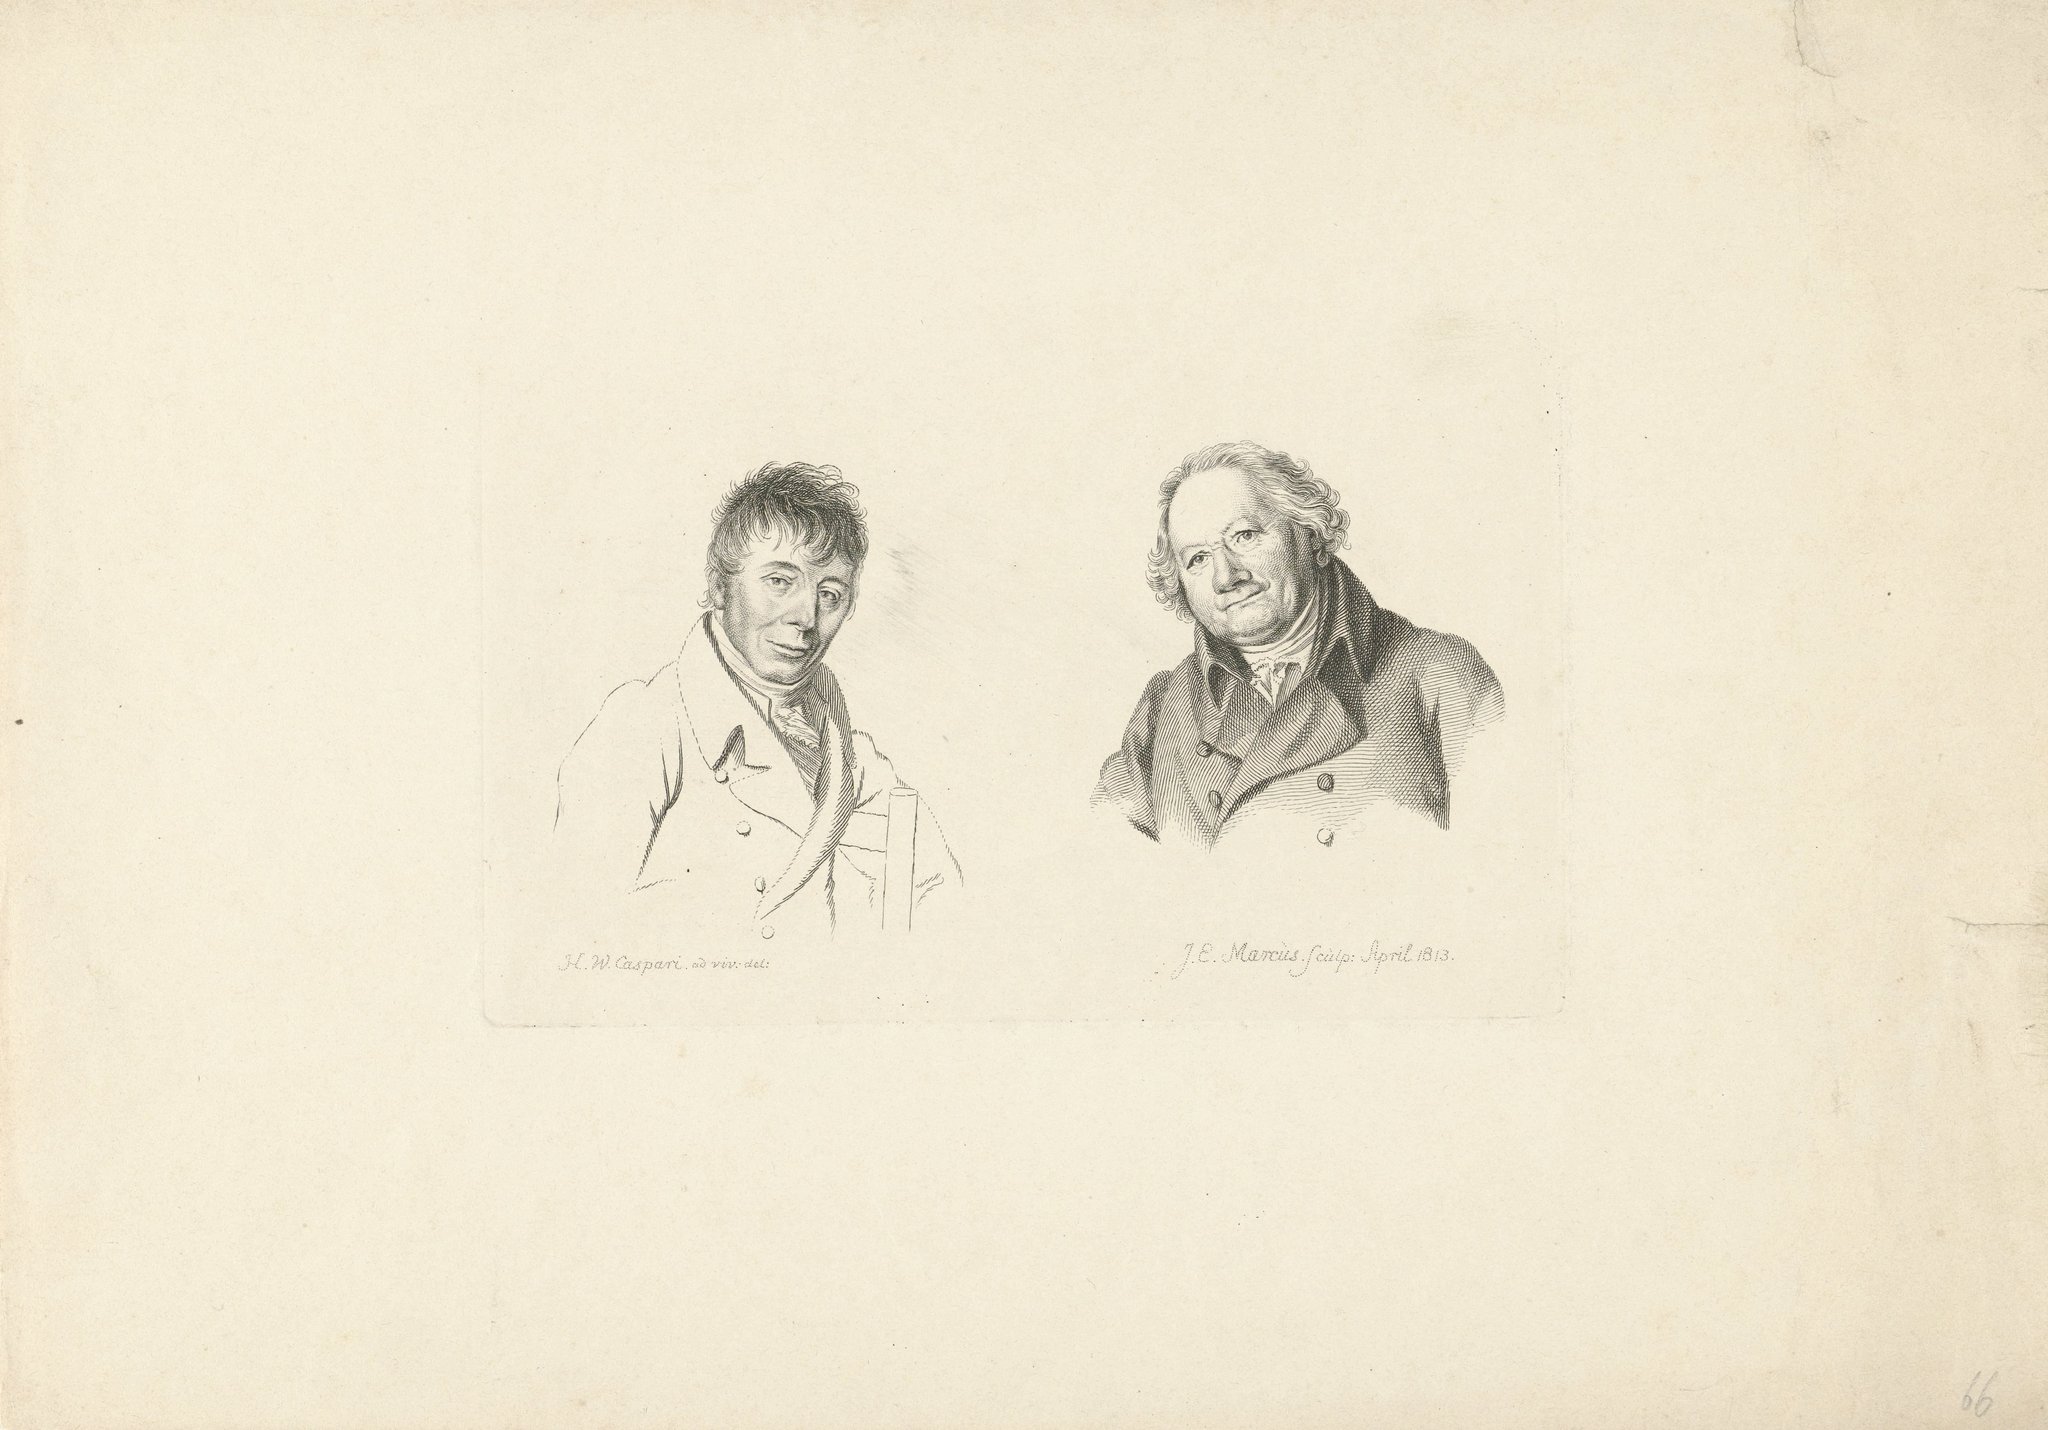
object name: print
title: Portretten van Daniël Dupré en Christiaan Welmeer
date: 1804-1813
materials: paper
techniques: etching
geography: amsterdam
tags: print maker, daniël dupré, amsterdam, draughtsman, christiaan welmeer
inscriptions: collector's mark: Lugt 2228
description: Serie voor het eerst uitgegeven door Jacob Ernst Marcus onder de titel Studiebeelden en Fragmenten. Amsterdam: ca.1816. Later heruitgegeven als: Studie-prentwerk/ Etudes gravées.